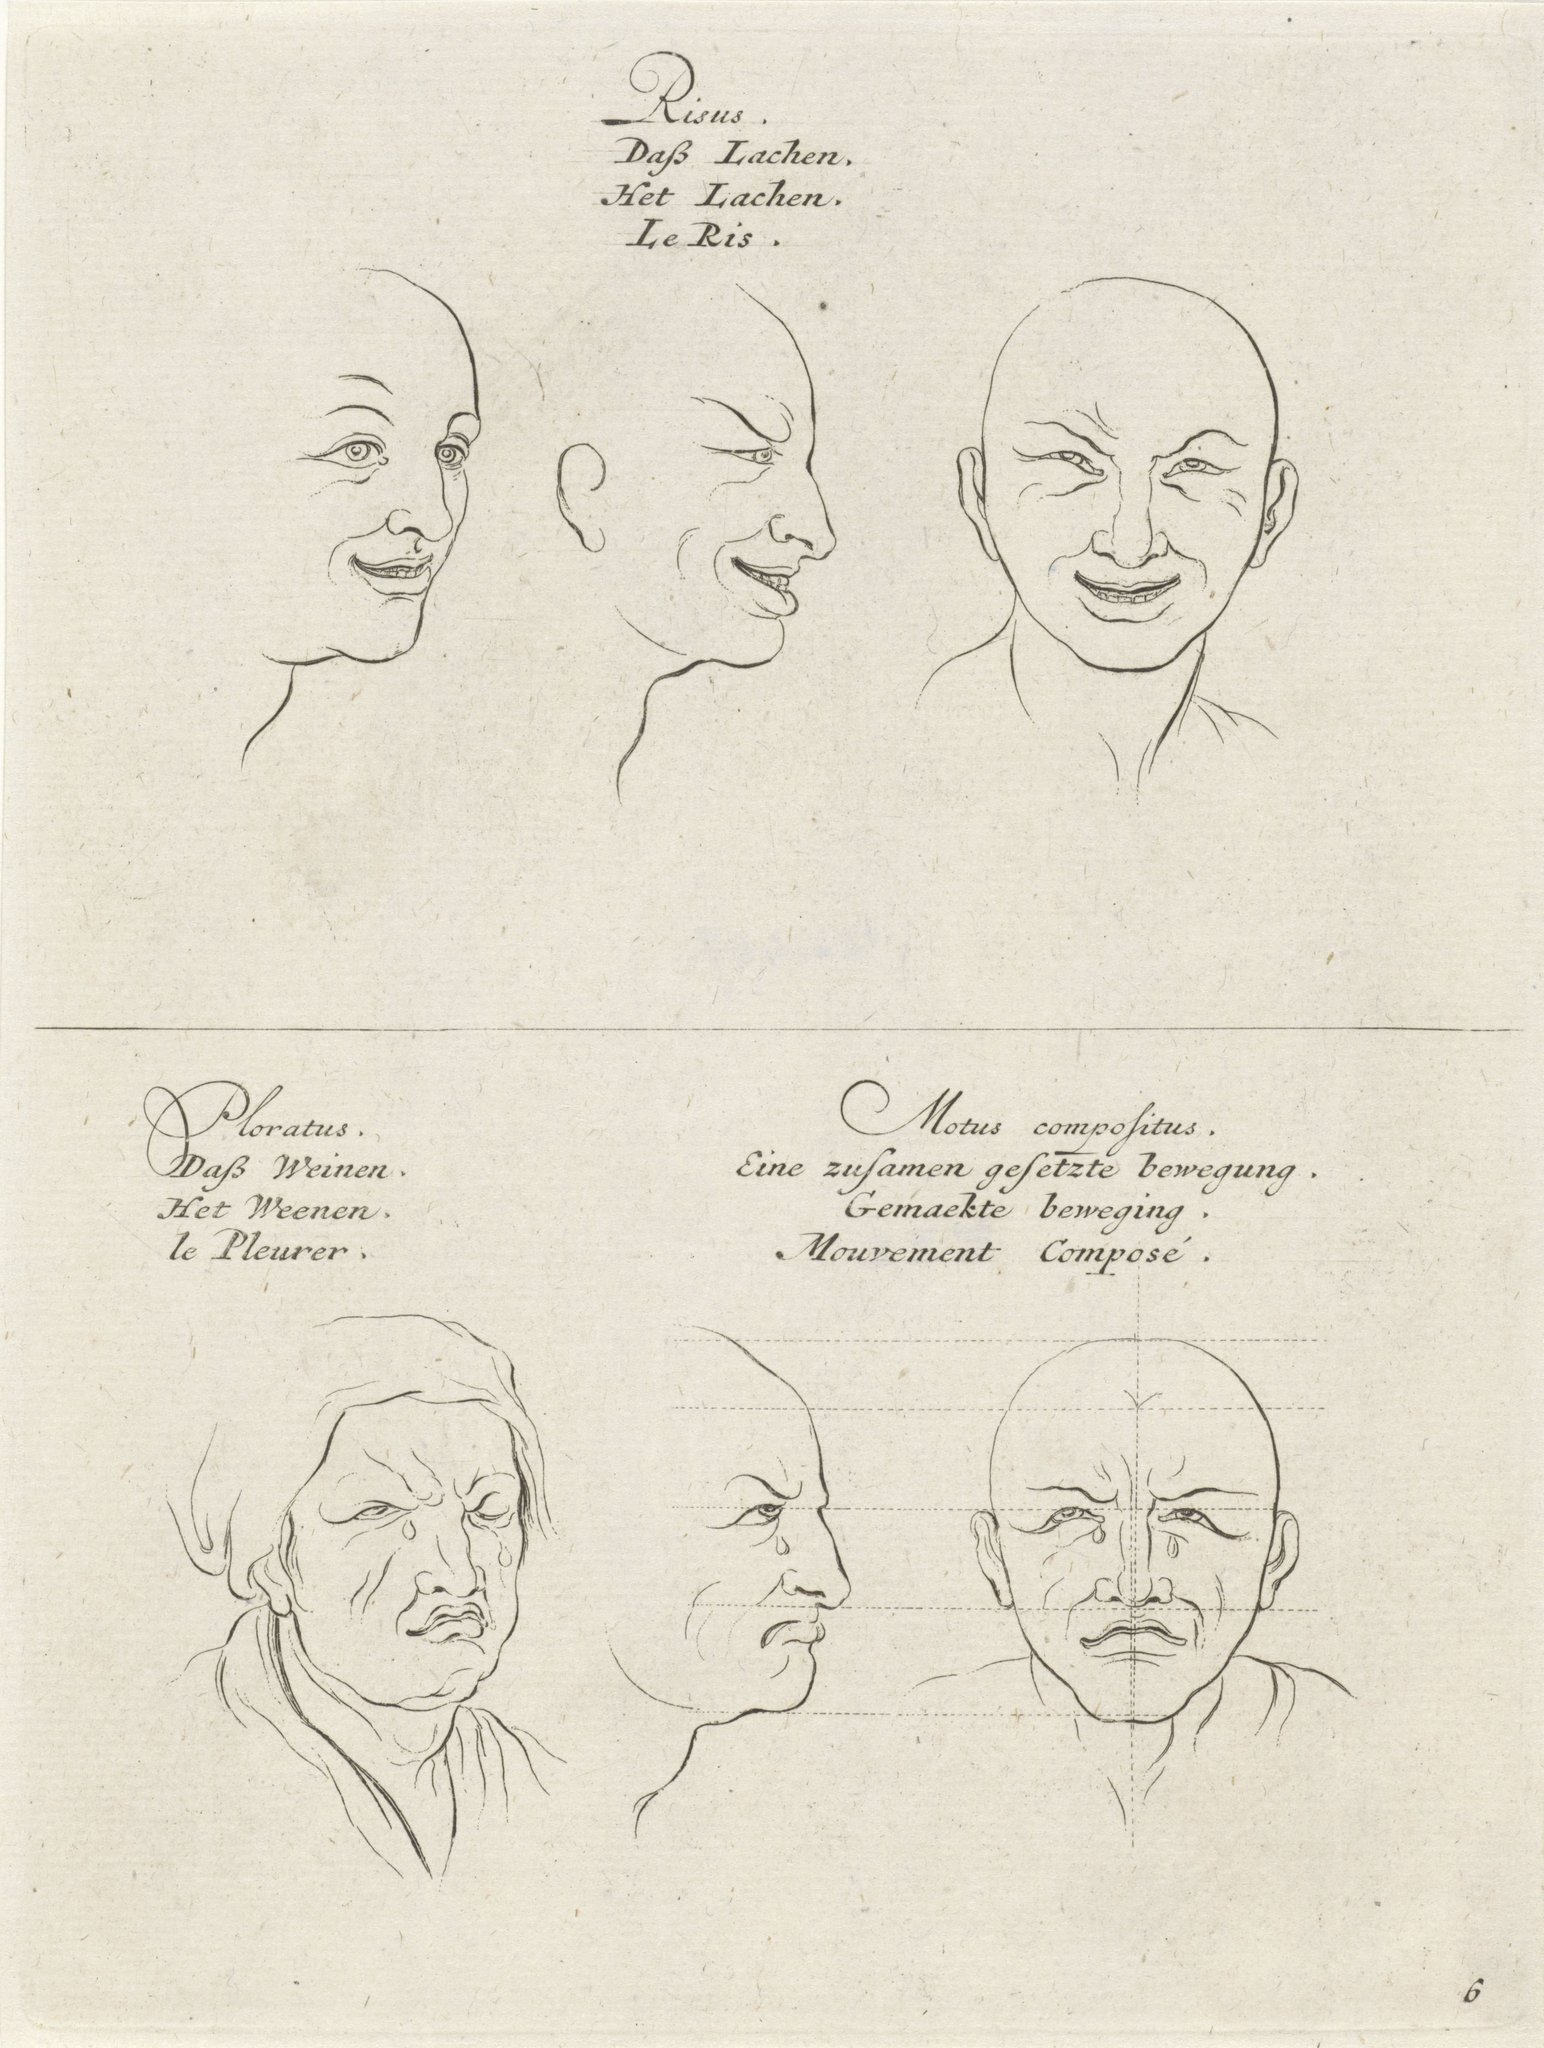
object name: print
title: Lachende en huilende gezichtsuitdrukking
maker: pieter schenk (i)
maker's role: print maker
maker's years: 1660-1711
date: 1692-1711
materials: paper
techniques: etching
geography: amsterdam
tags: morphology of facial expression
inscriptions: collector's mark: Lugt 2233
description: Bovenaan twee gezichten van opzij en een van voren met een lachende gezichtsuitdrukking. Onderaan een gezicht van voren en van opzij met een huilende gezichtsuitdrukking.